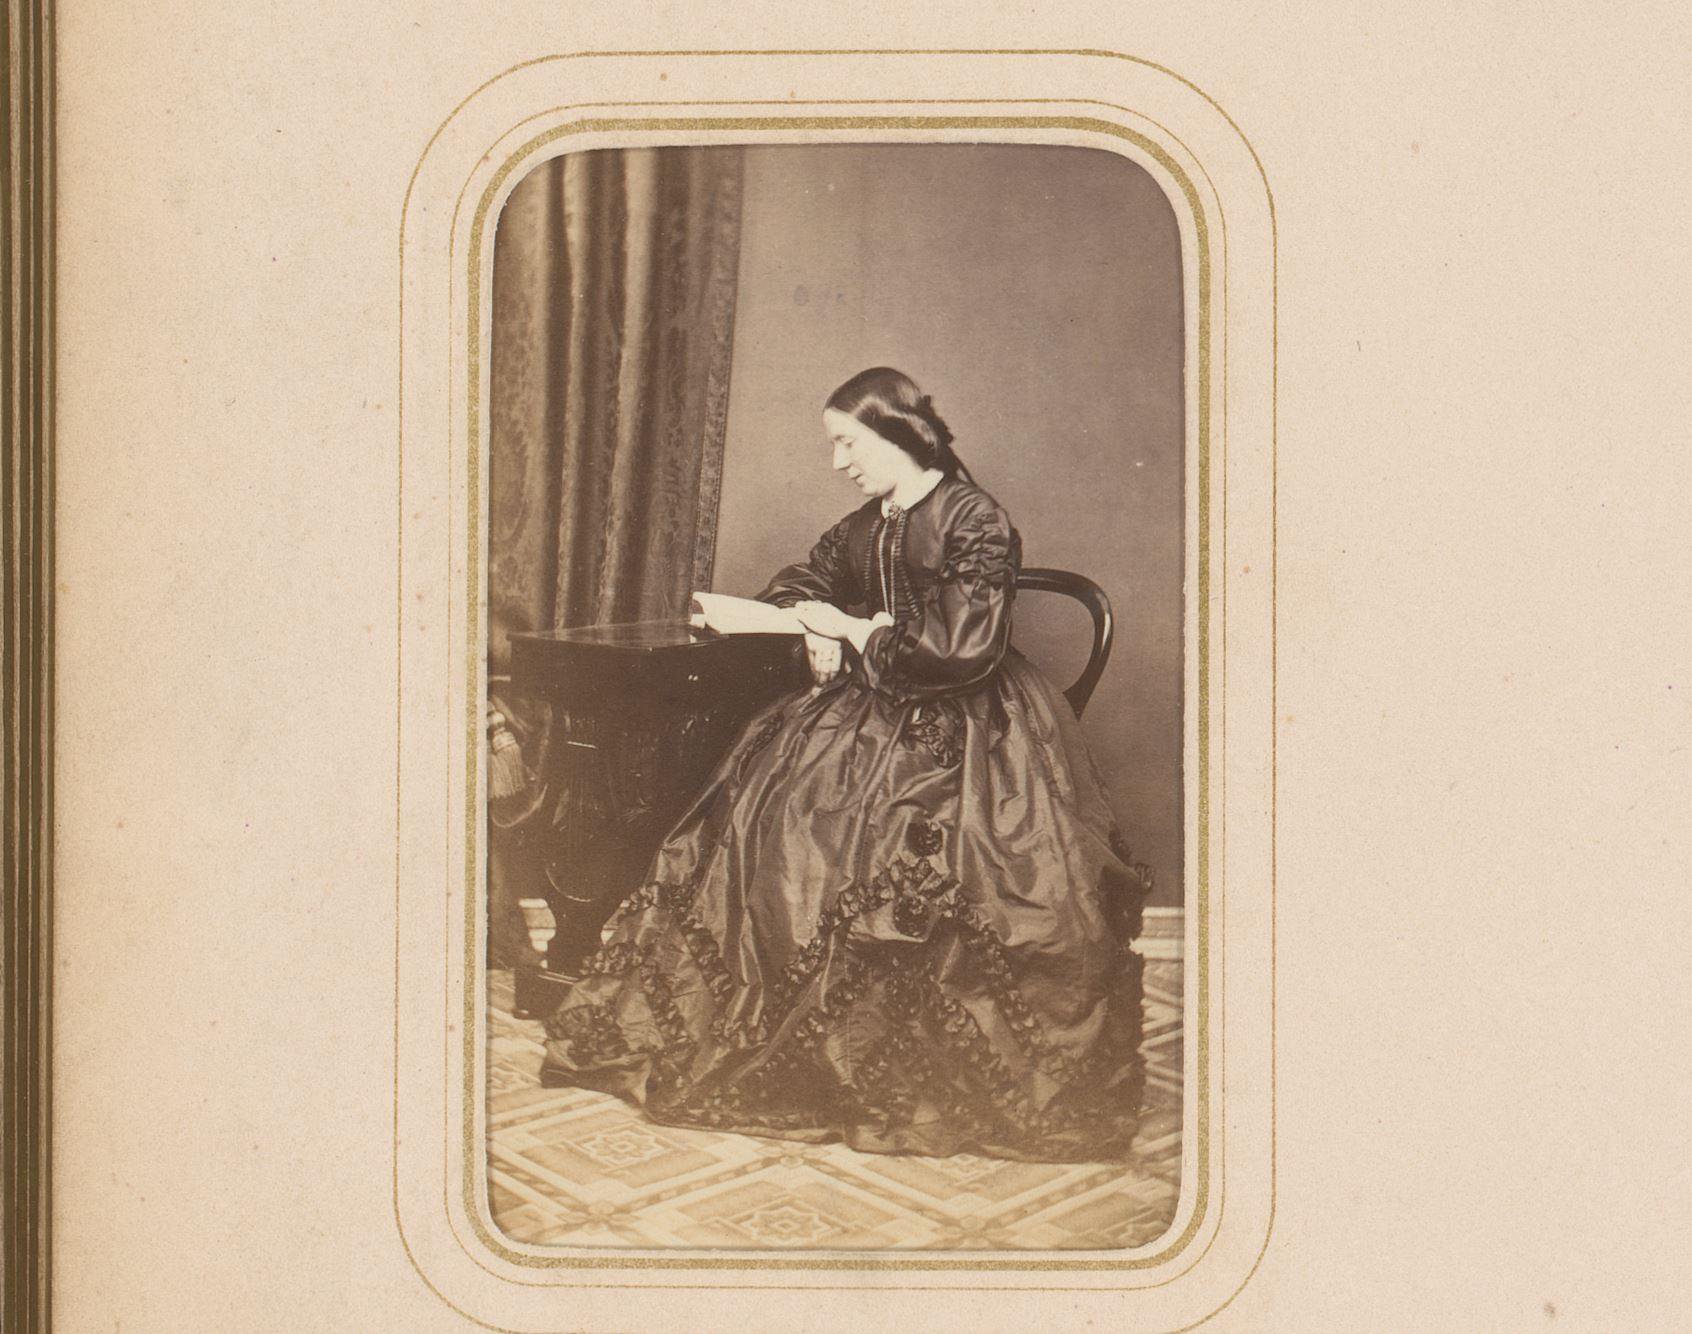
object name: carte de visite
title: Portret van een lezende vrouw, zittend aan een tafel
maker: Anonymous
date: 1860-1900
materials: cardboard, photographic support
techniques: albumen print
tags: reading, sitting figure - aa - female human figure, historical persons - bb - woman, table